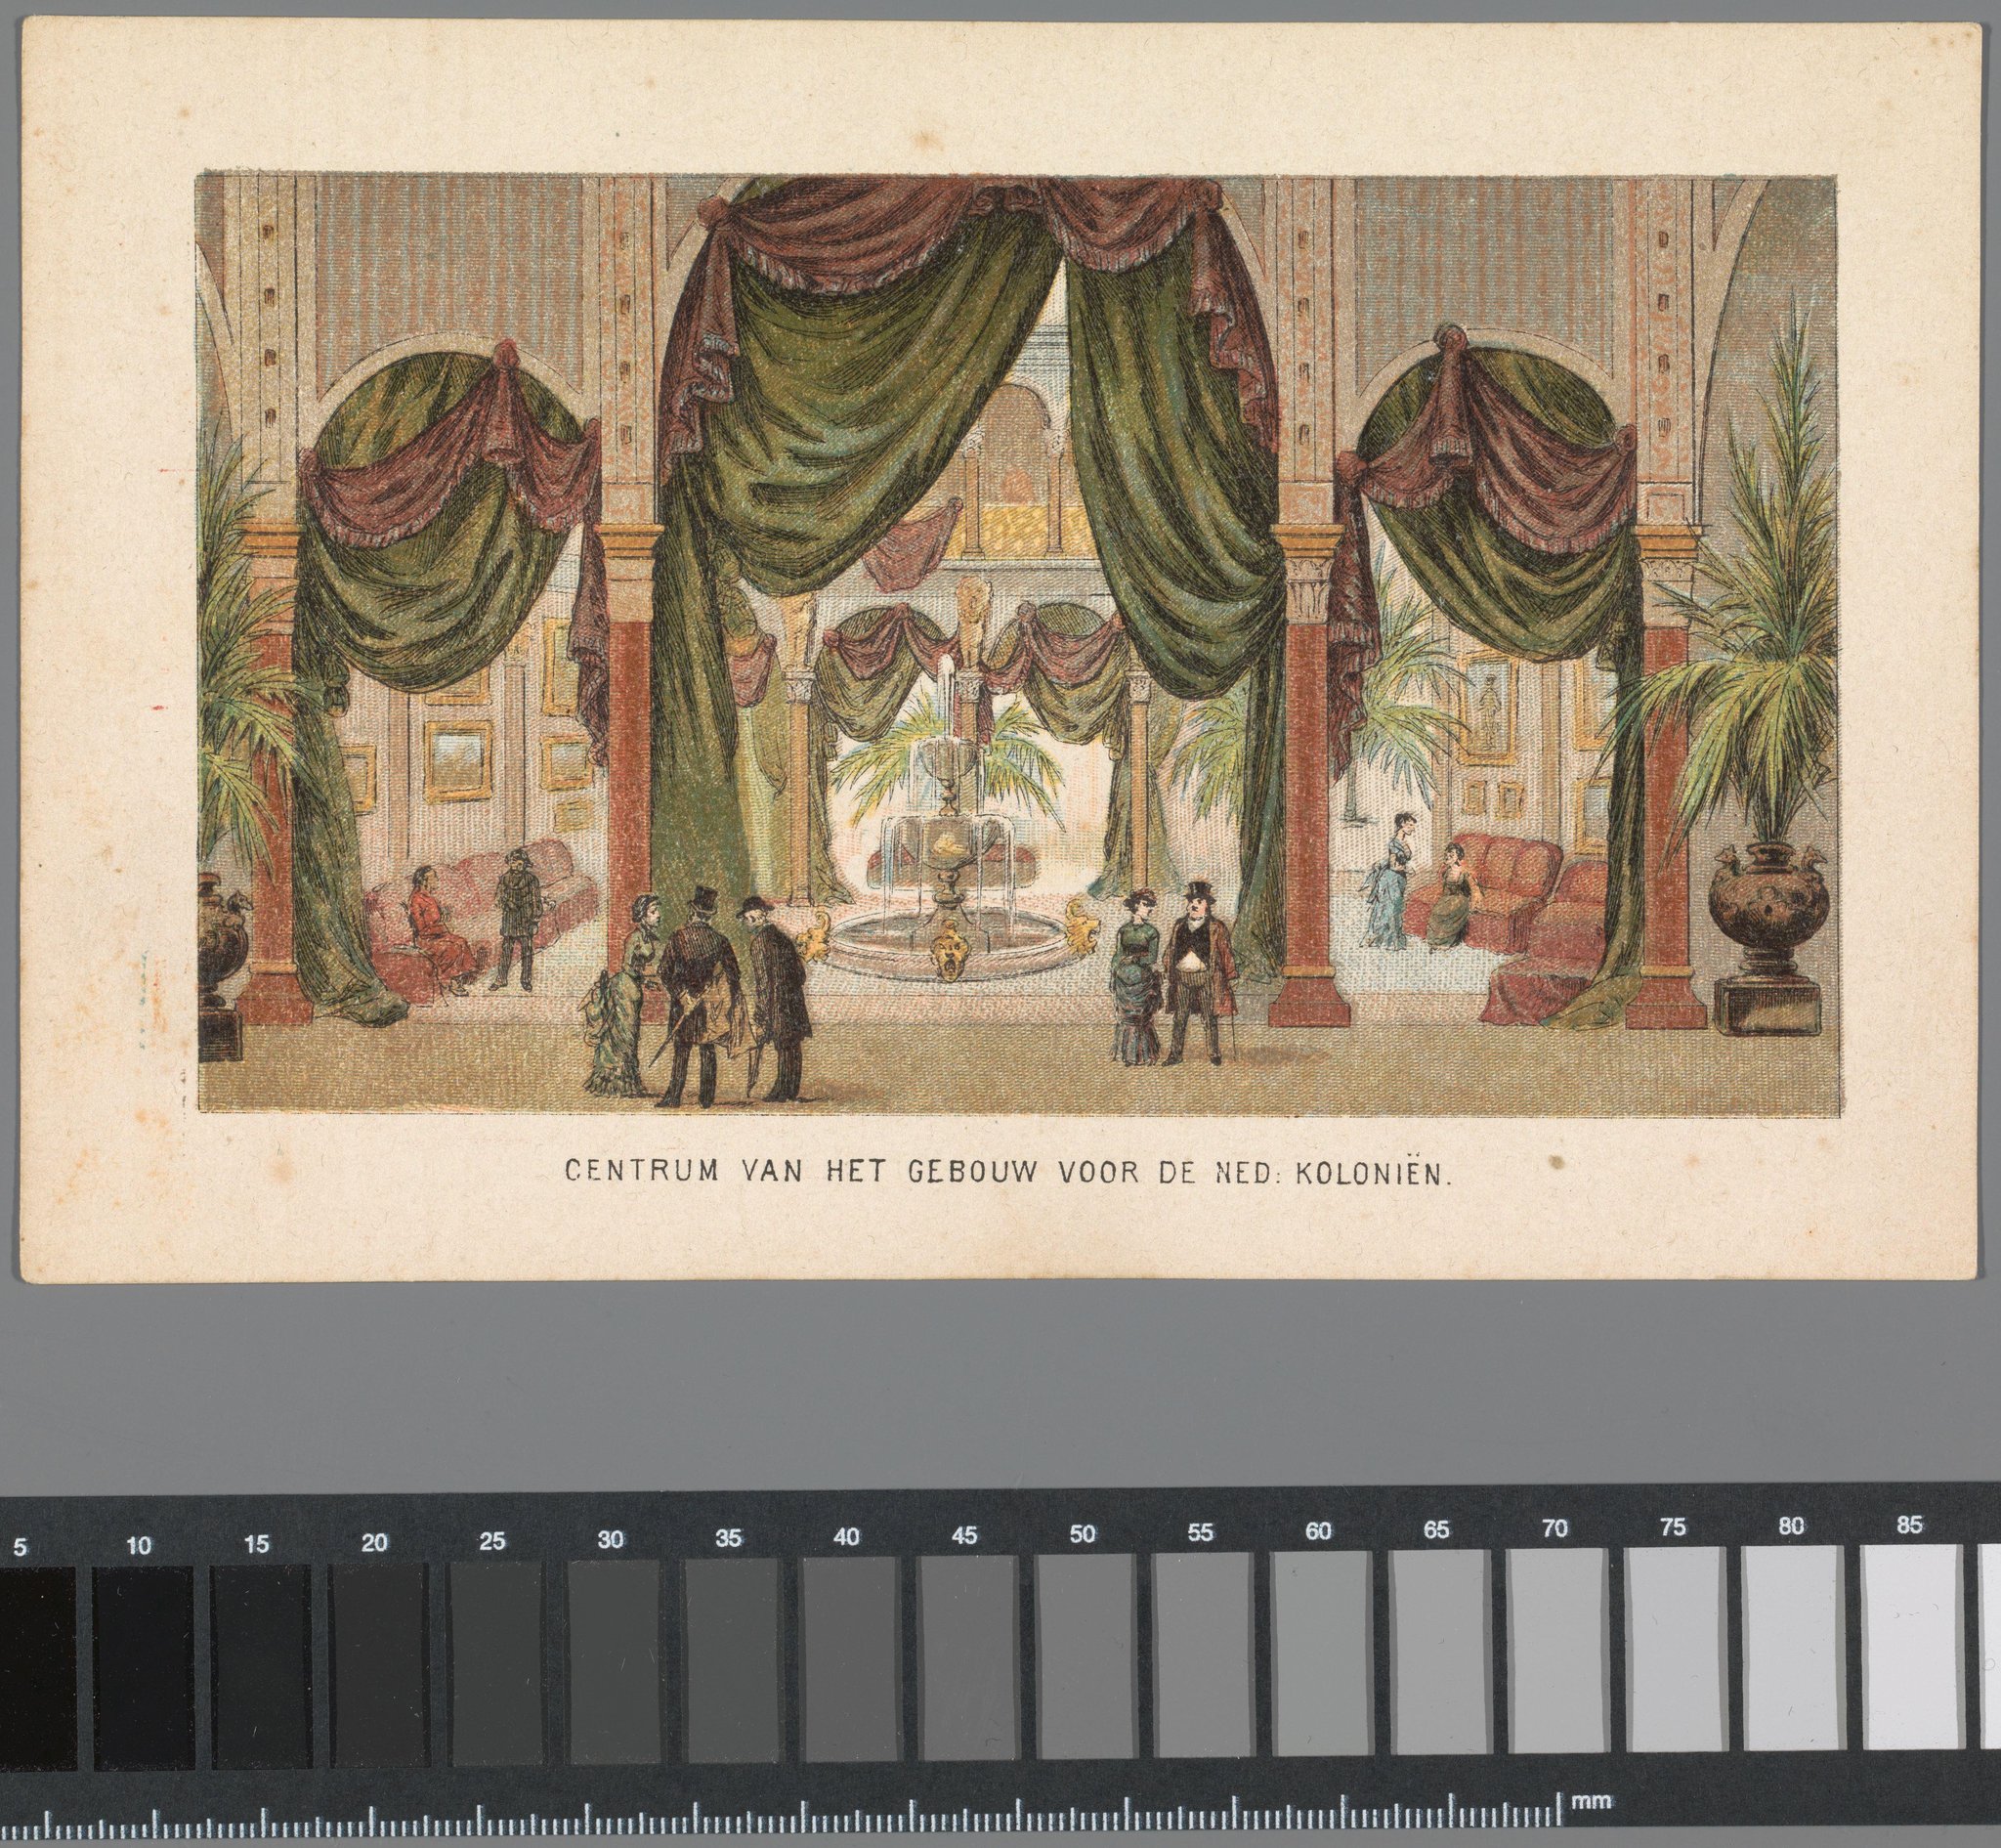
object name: print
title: Herinnering aan Amsterdam in 1883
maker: Anonymous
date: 1883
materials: paper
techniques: chromolithography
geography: amsterdam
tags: world fair, world exhibition, amsterdam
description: Gezicht in het Gebouw voor de Nederlandse koloniën op de Wereldtentoonstelling op het Museumplein te Amsterdam. Onderdeel van een groep van zestien platen en een plattegrond van de Wereldtentoonstelling in Amsterdam van 1 mei tot 1 oktober 1883. Uitgave van het Nieuws van den Dag.